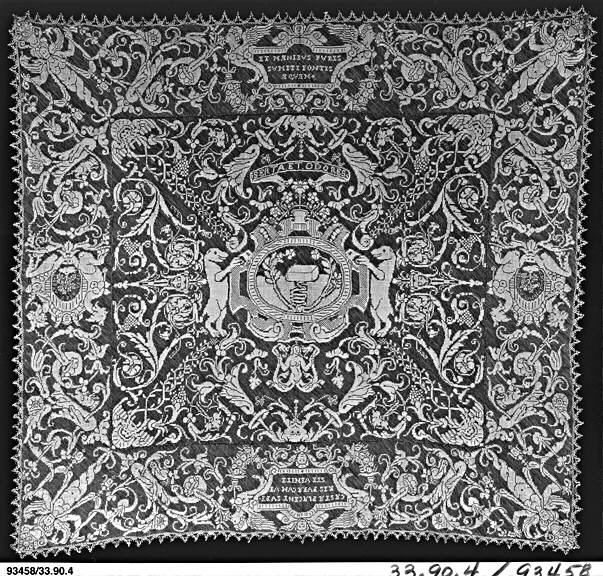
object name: veil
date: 1601-1700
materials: linen, metal thread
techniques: embroidery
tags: coat of arms